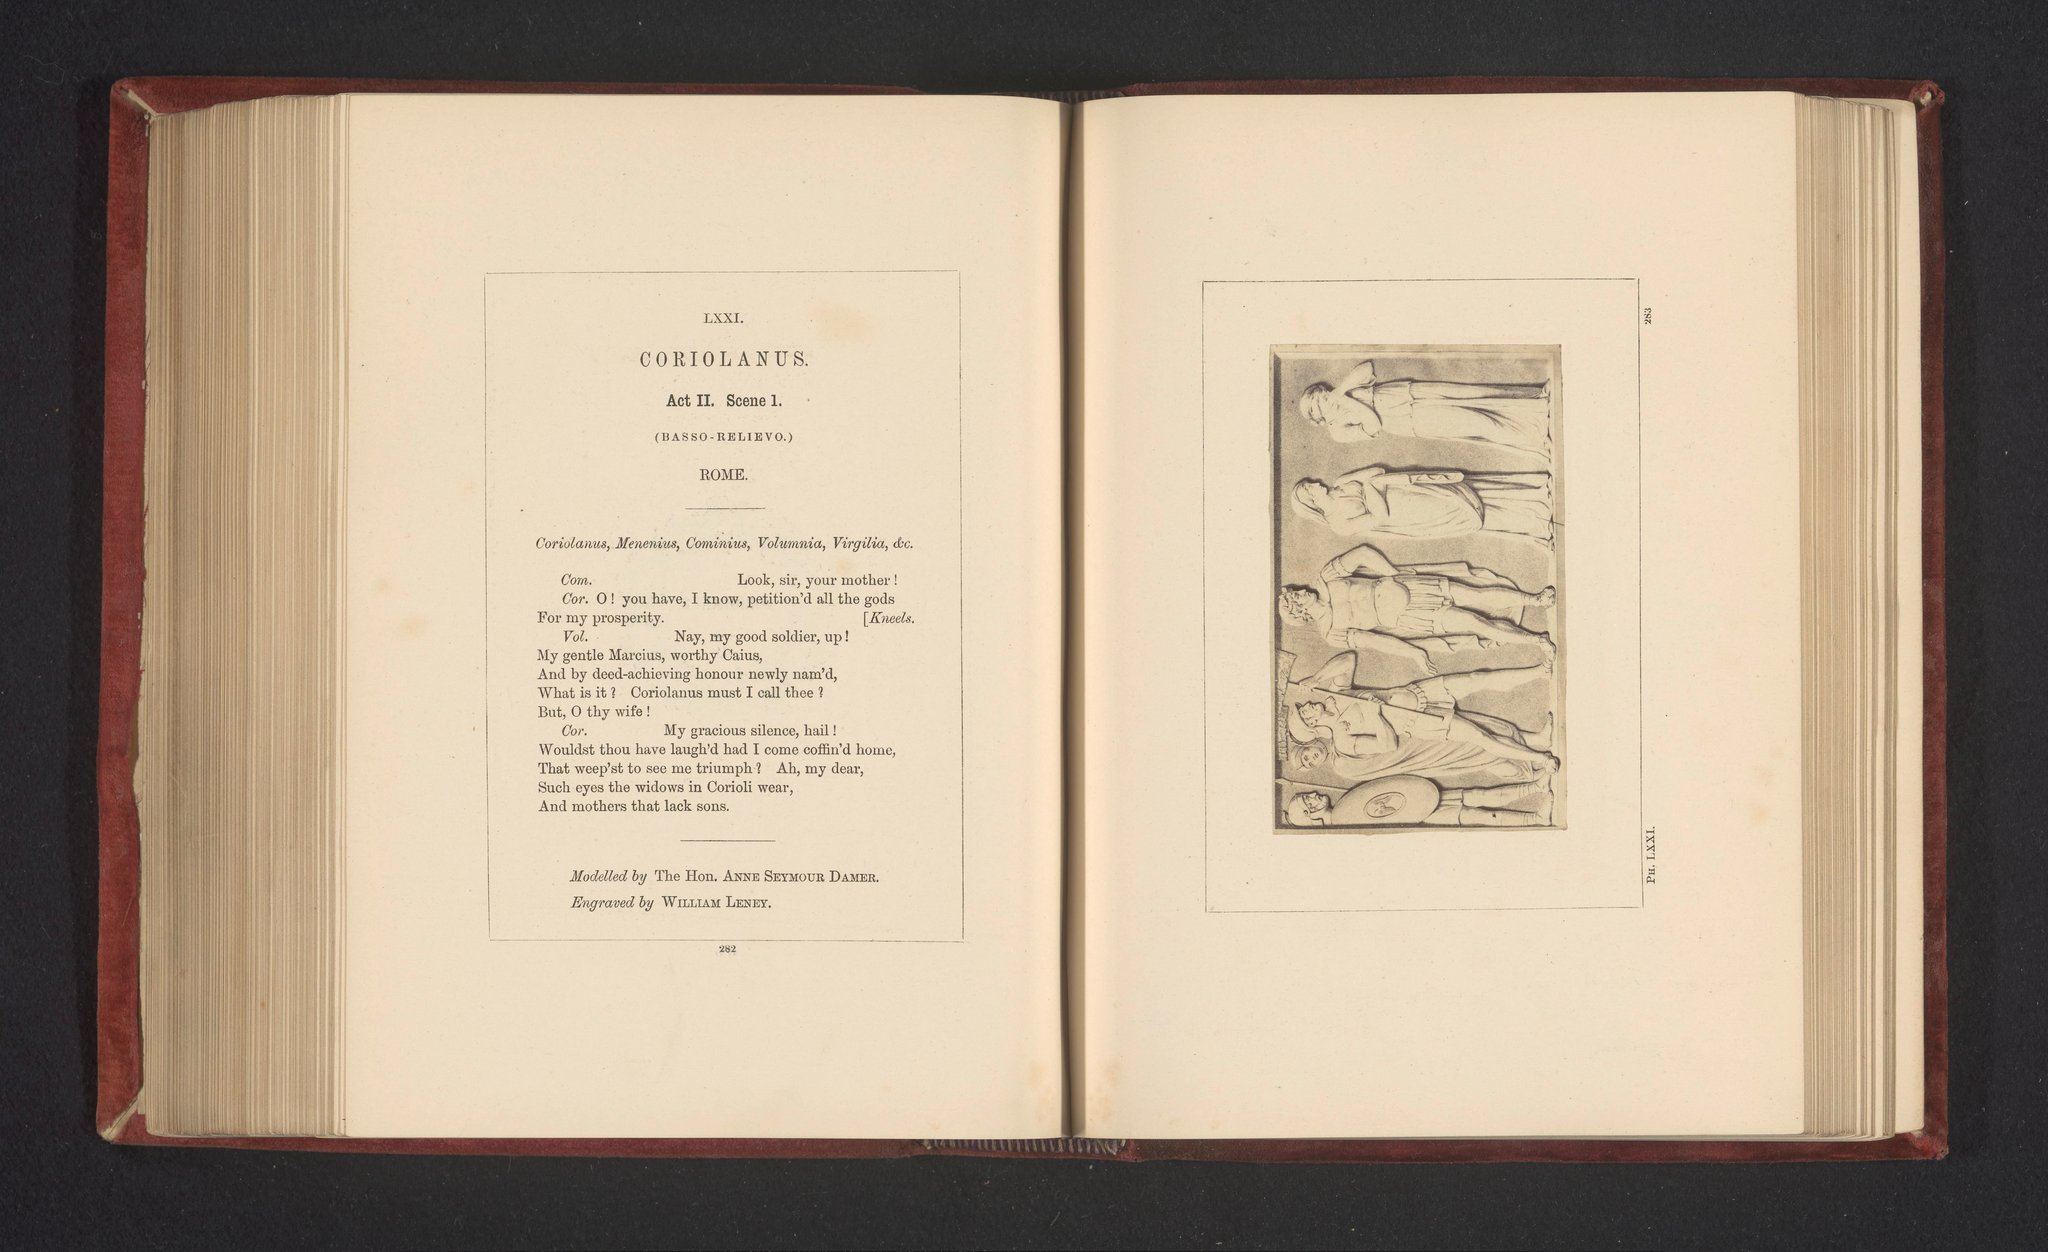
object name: photograph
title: Fotoreproductie van een prent naar een reliëf door Anne Seymour Damer, voorstellend een scene uit Coriolanus door William Shakespeare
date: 1854-1864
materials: photographic support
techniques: albumen print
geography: london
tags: specific works of literature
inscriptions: number: ‘Ph. LXXI. 283’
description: Te zien is akte II, scene 1 met zes figuren op een rij.